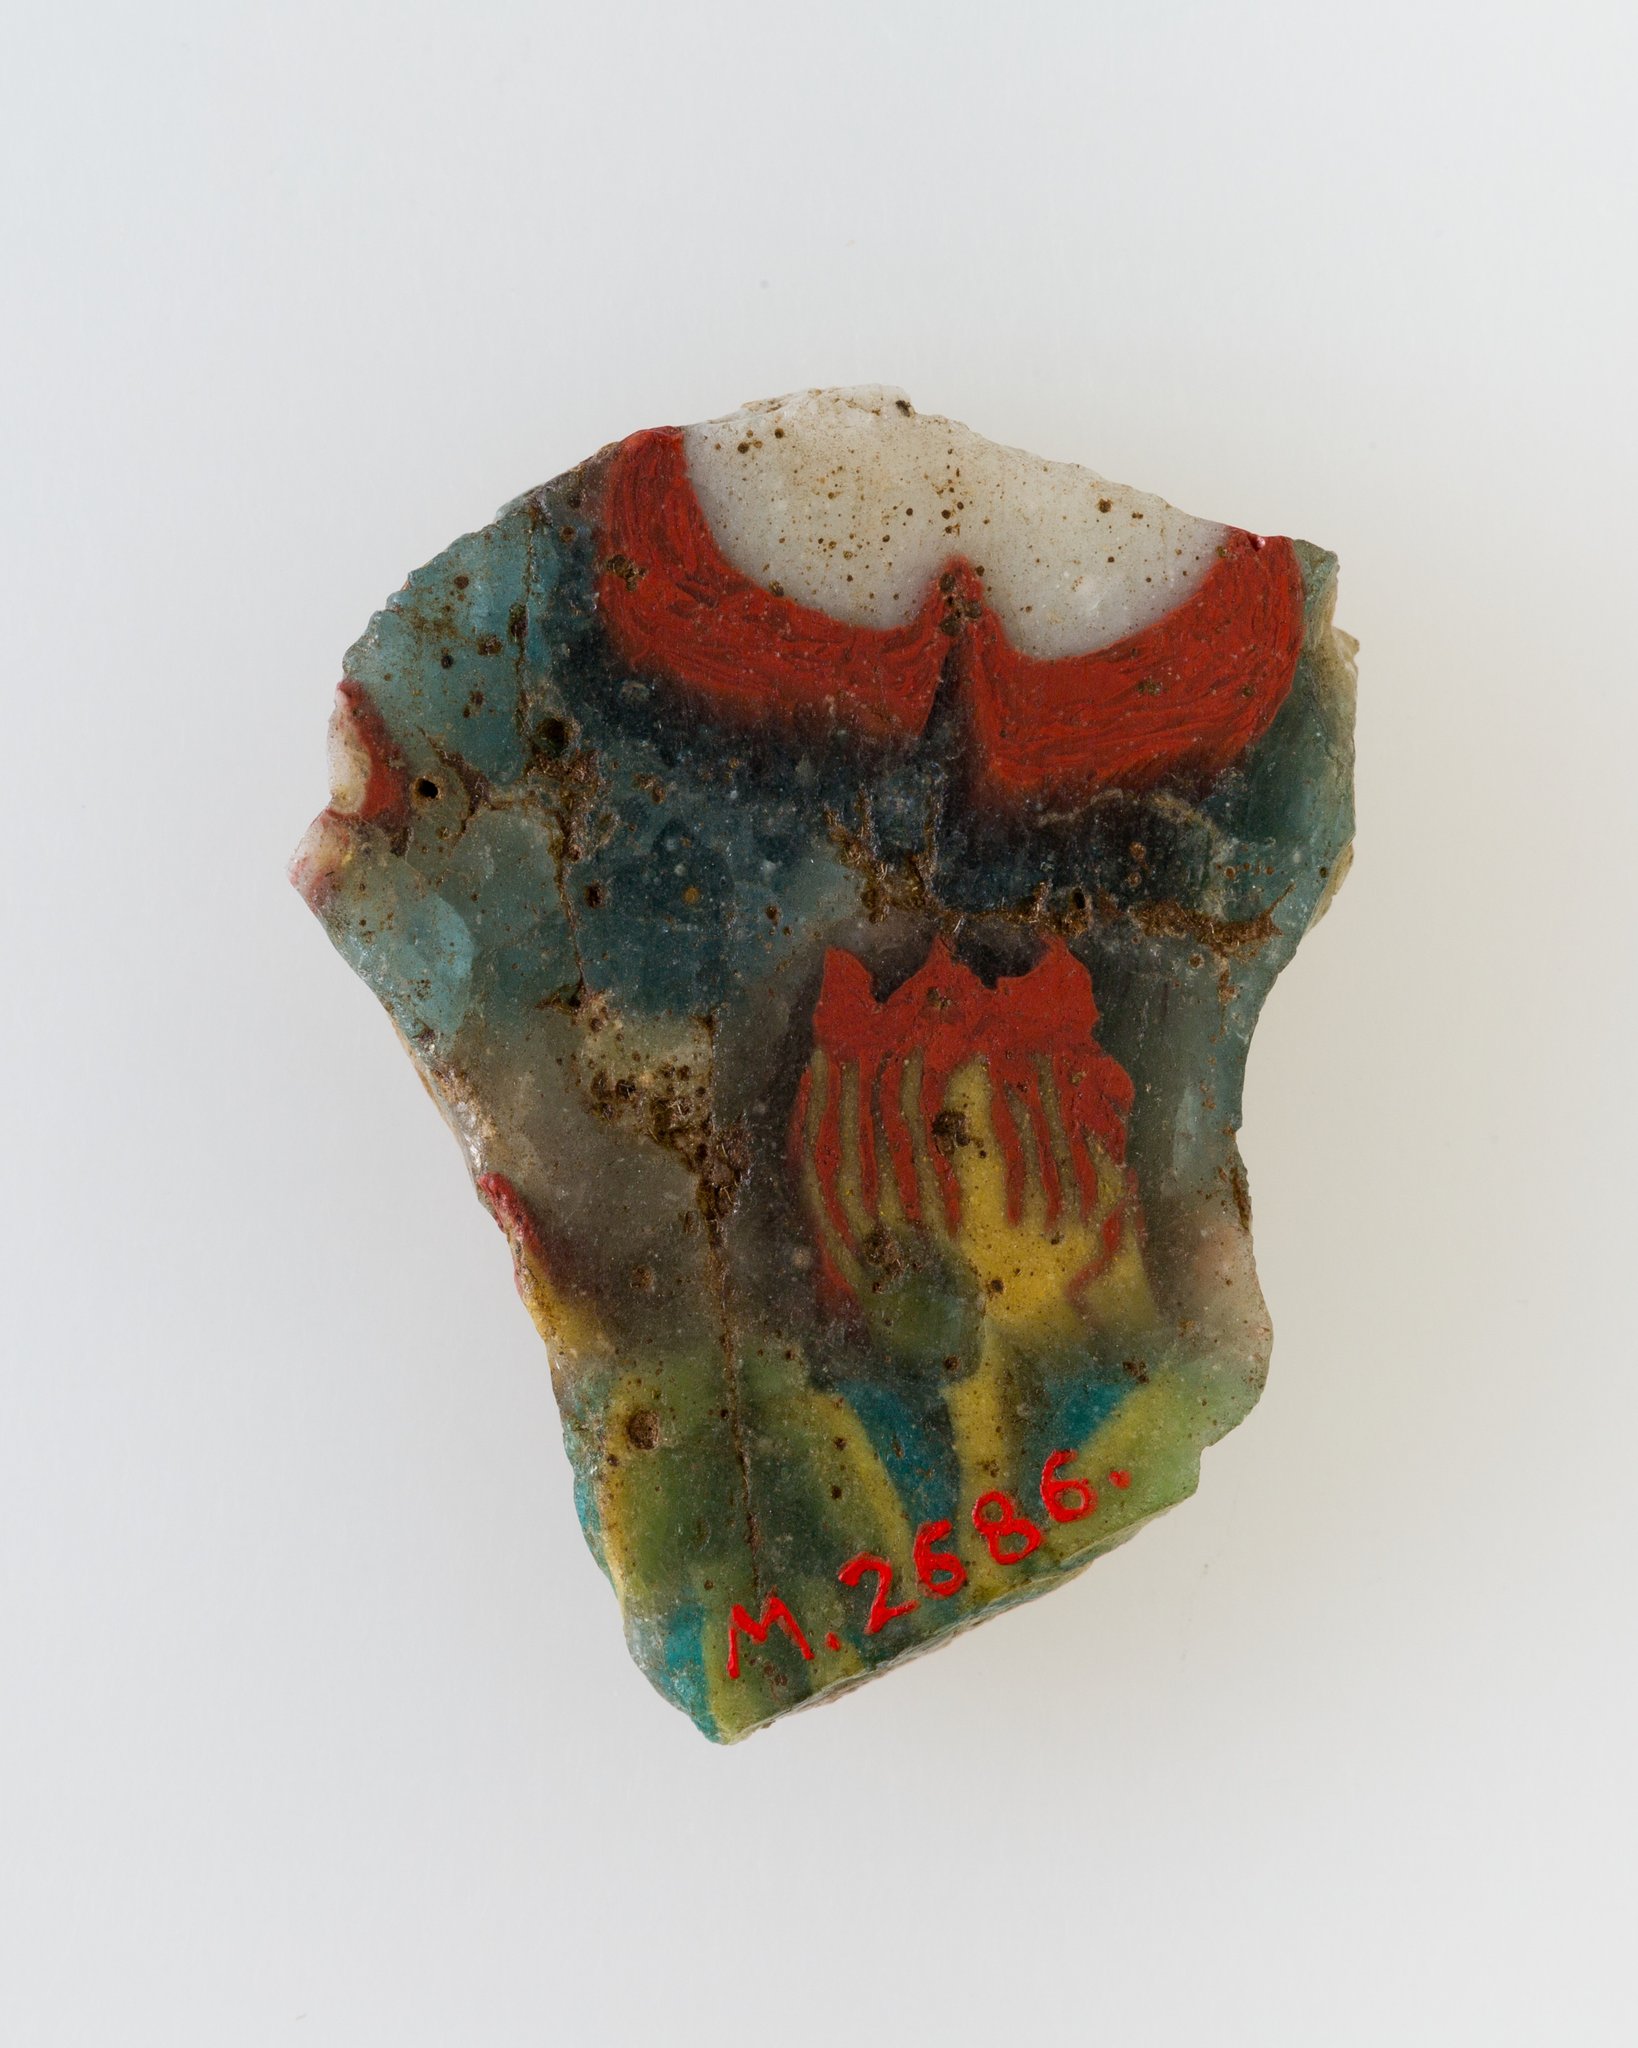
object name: plaque, floral, inlay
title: Floral plaque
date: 100 BCE-100 CE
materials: glass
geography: egypt